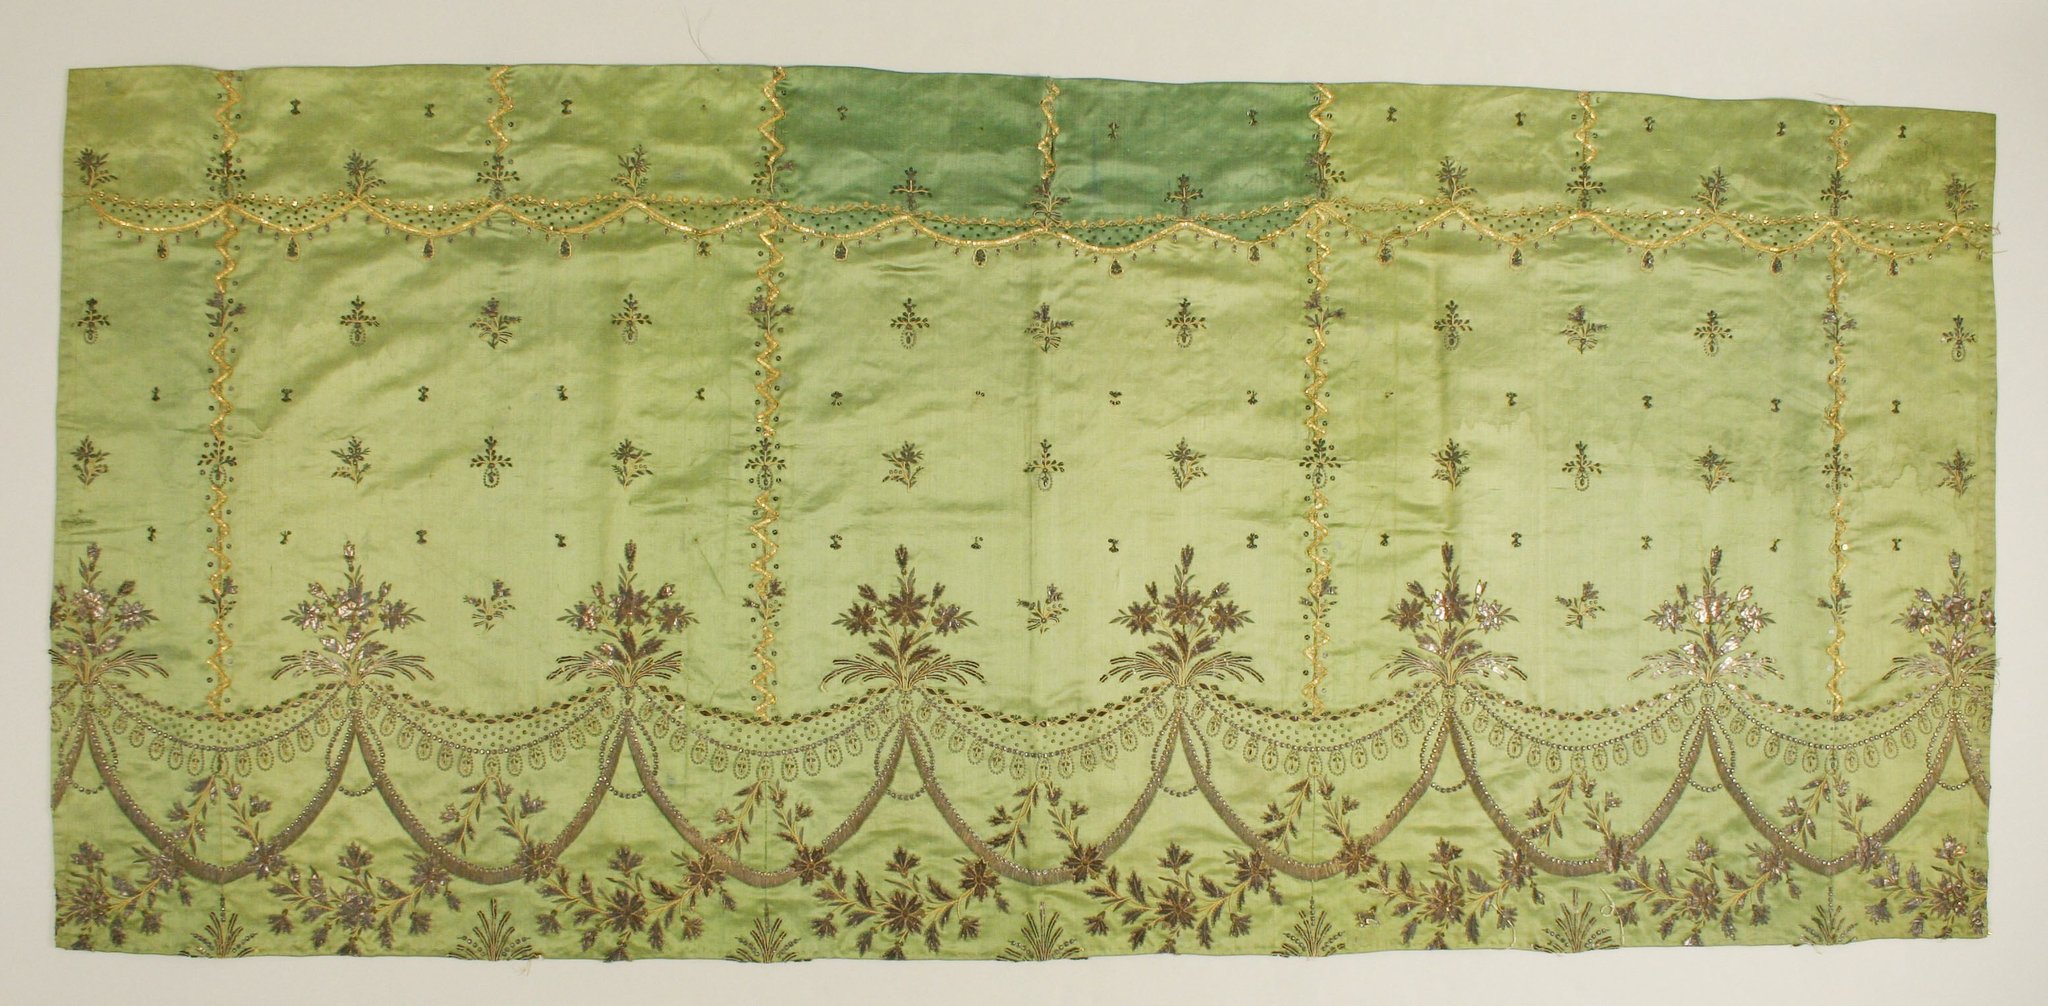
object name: skirt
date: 1701-1800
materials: metal thread, silk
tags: flowers